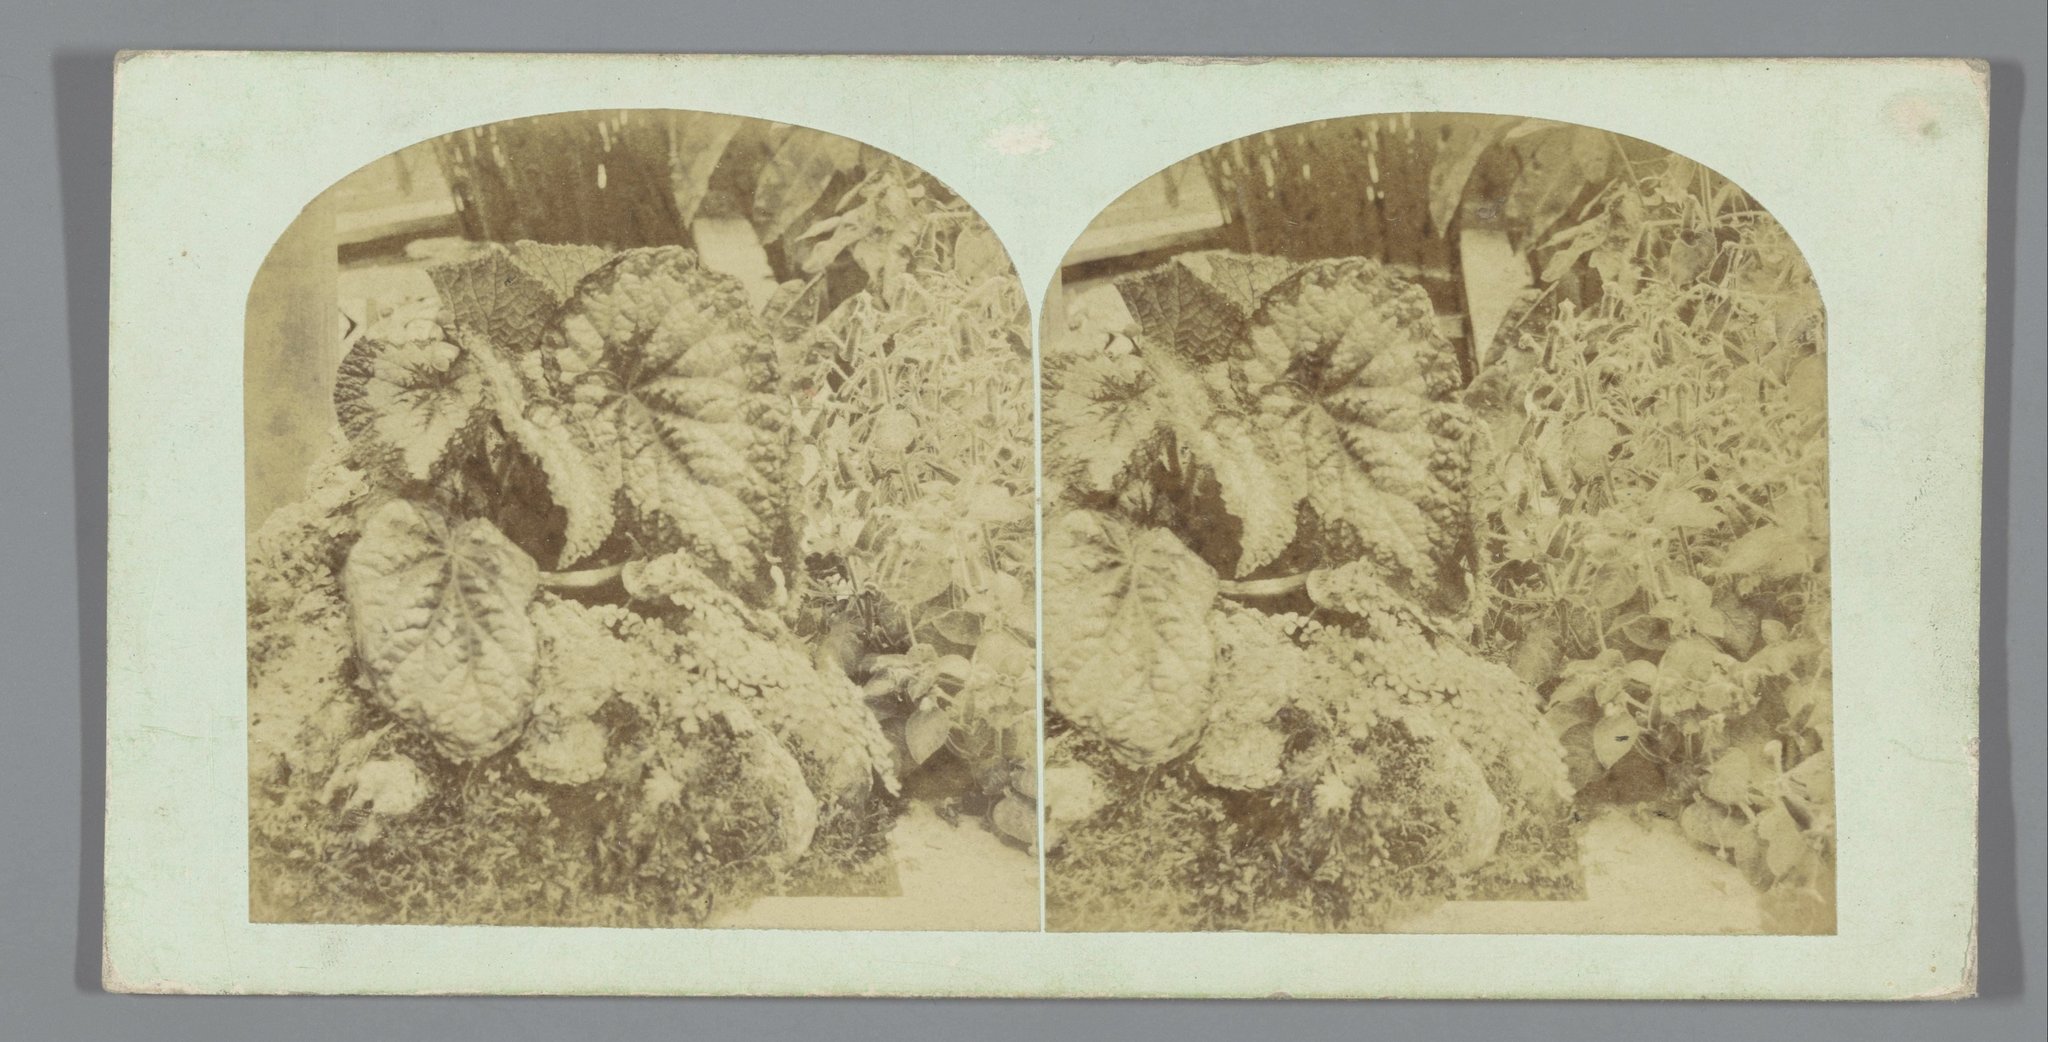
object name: stereograph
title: Begonia, Duchess of Brabant, at Chatsworth-Derbyshire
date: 1855-1870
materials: cardboard, photographic support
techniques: albumen print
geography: manchester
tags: plants; vegetation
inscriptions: label: ‘84, Market Street, Manchester’, number: ‘381’